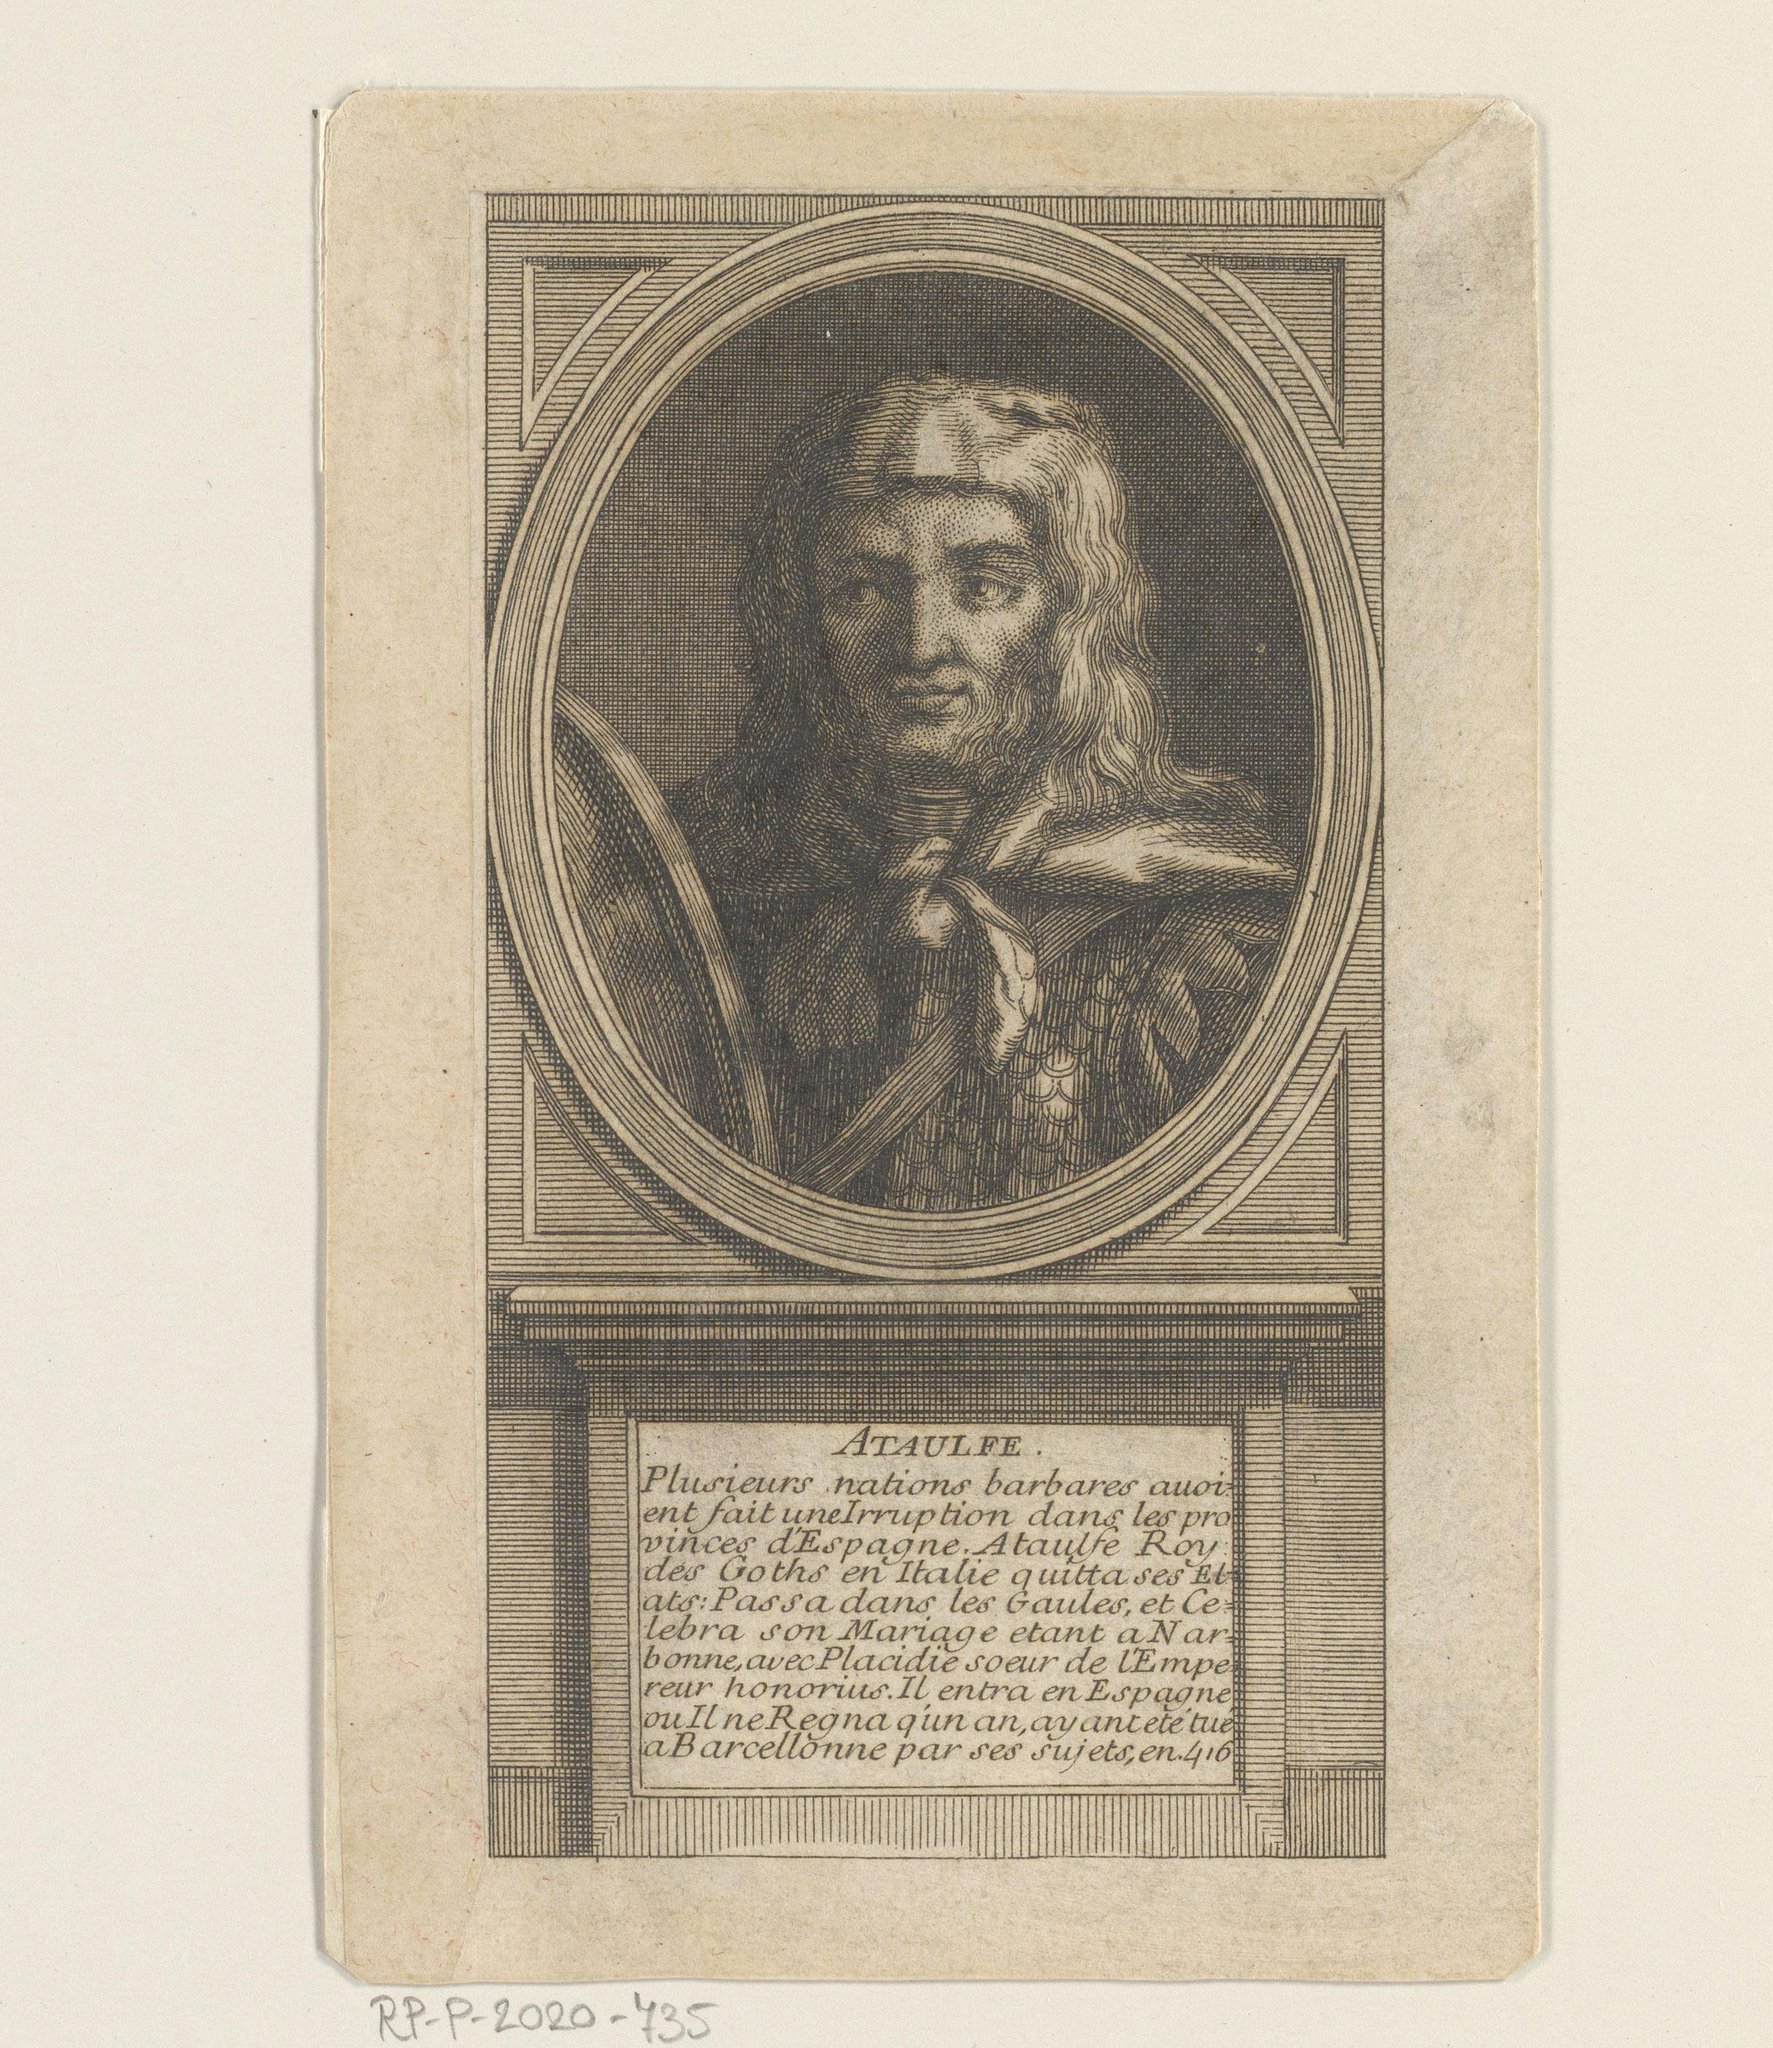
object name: print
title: Ataulfe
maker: Anonymous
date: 1650-1749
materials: paper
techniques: engraving, etching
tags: historical persons, ruler, sovereign